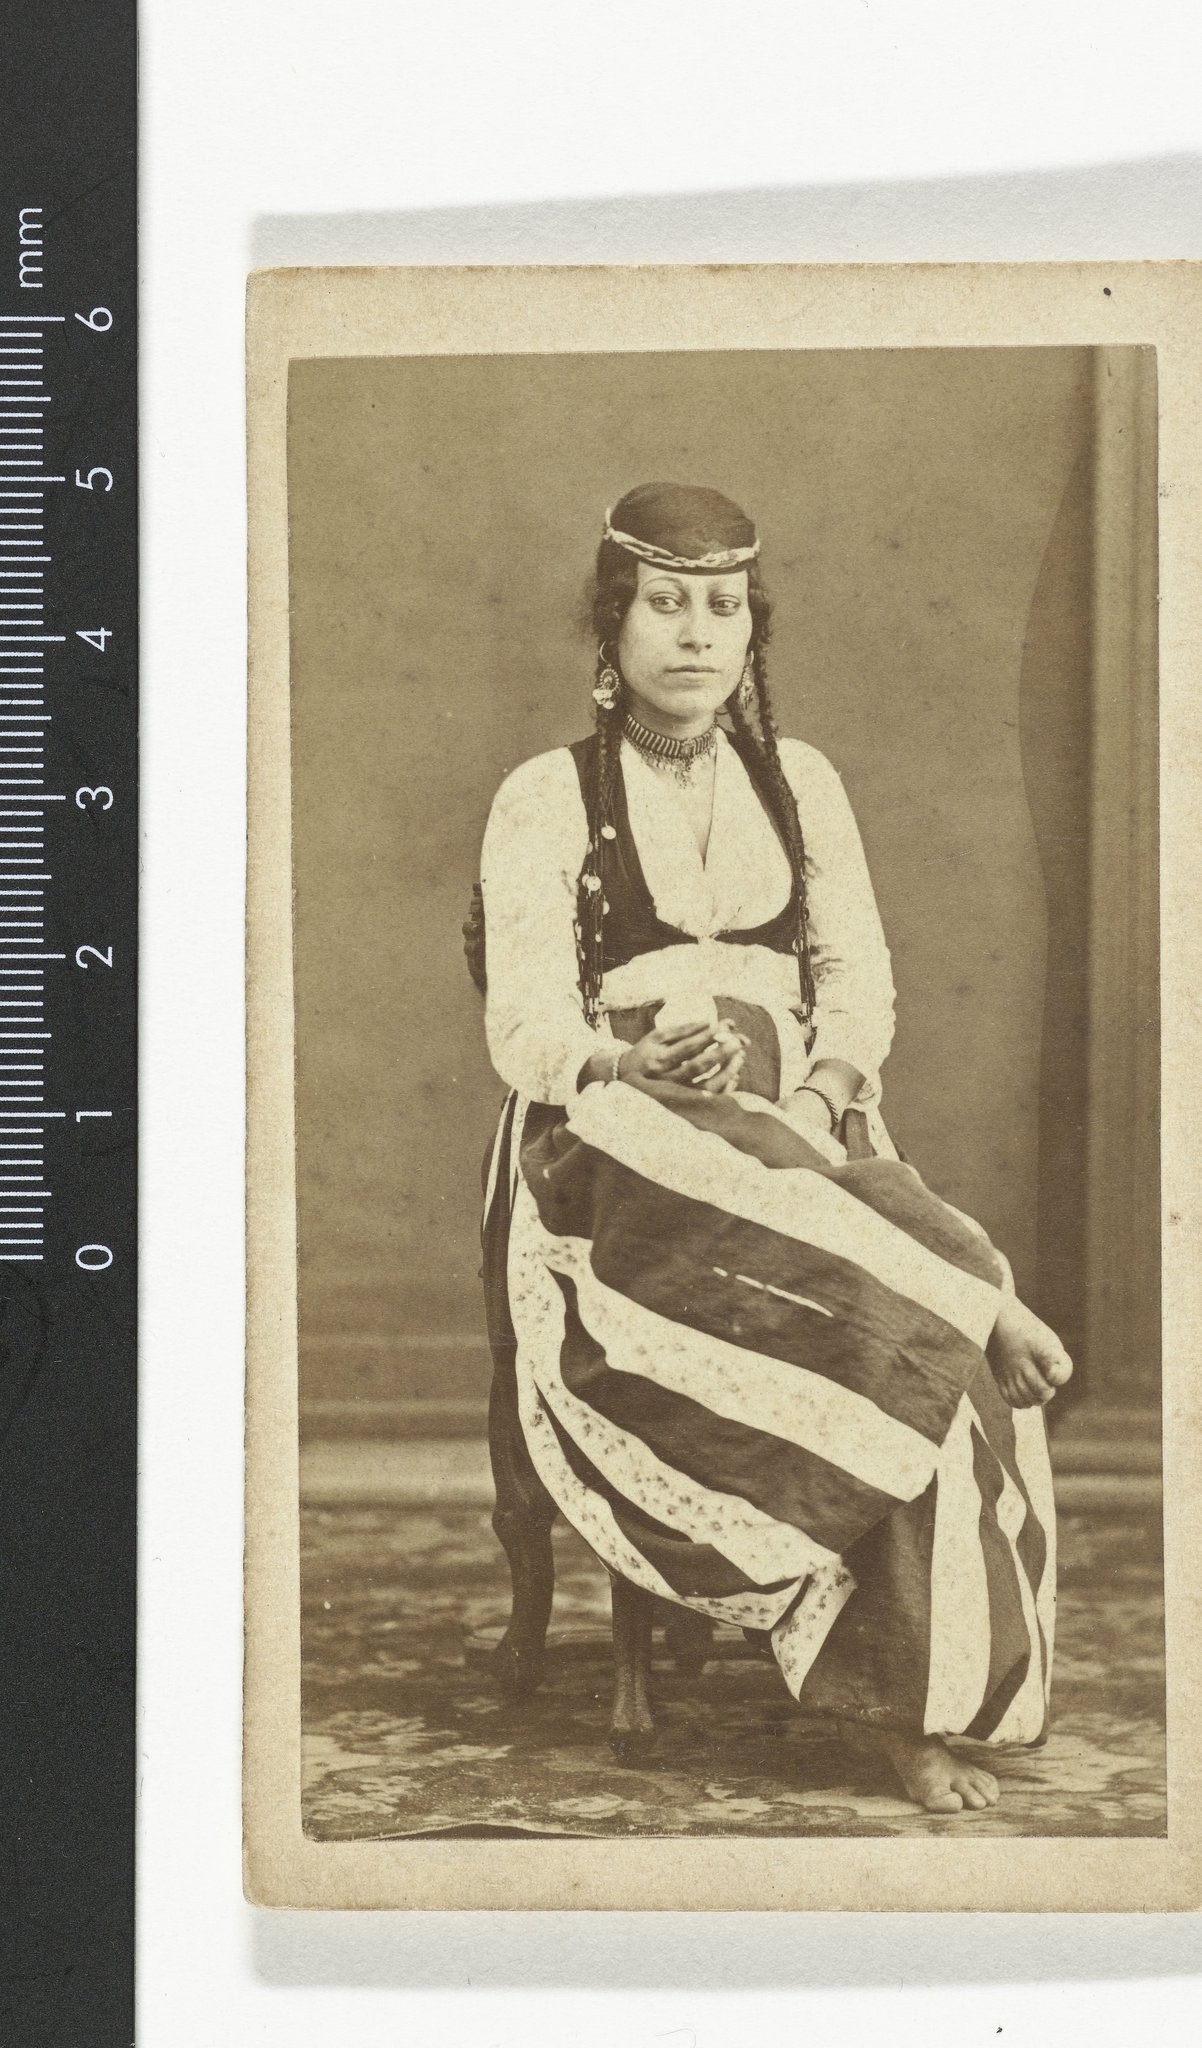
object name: photograph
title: Portret van een Ghawazi-danseres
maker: Anonymous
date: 1870-1900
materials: cardboard, paper, photographic support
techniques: albumen print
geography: egypt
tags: dancer (non-work situations), historical persons not known by name - bb - woman, female dancer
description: Studioportret van een vrouw op een stoel. De vrouw draagt vlechten, sieraden en een hoofddeksel, verder draagt zij een pofbroek met strepen. Haar kleding en haardracht zijn kenmerkend voor Ghawazi. Haar armbanden zijn van het type mabroumi, haar halssieraad is een kirdan.